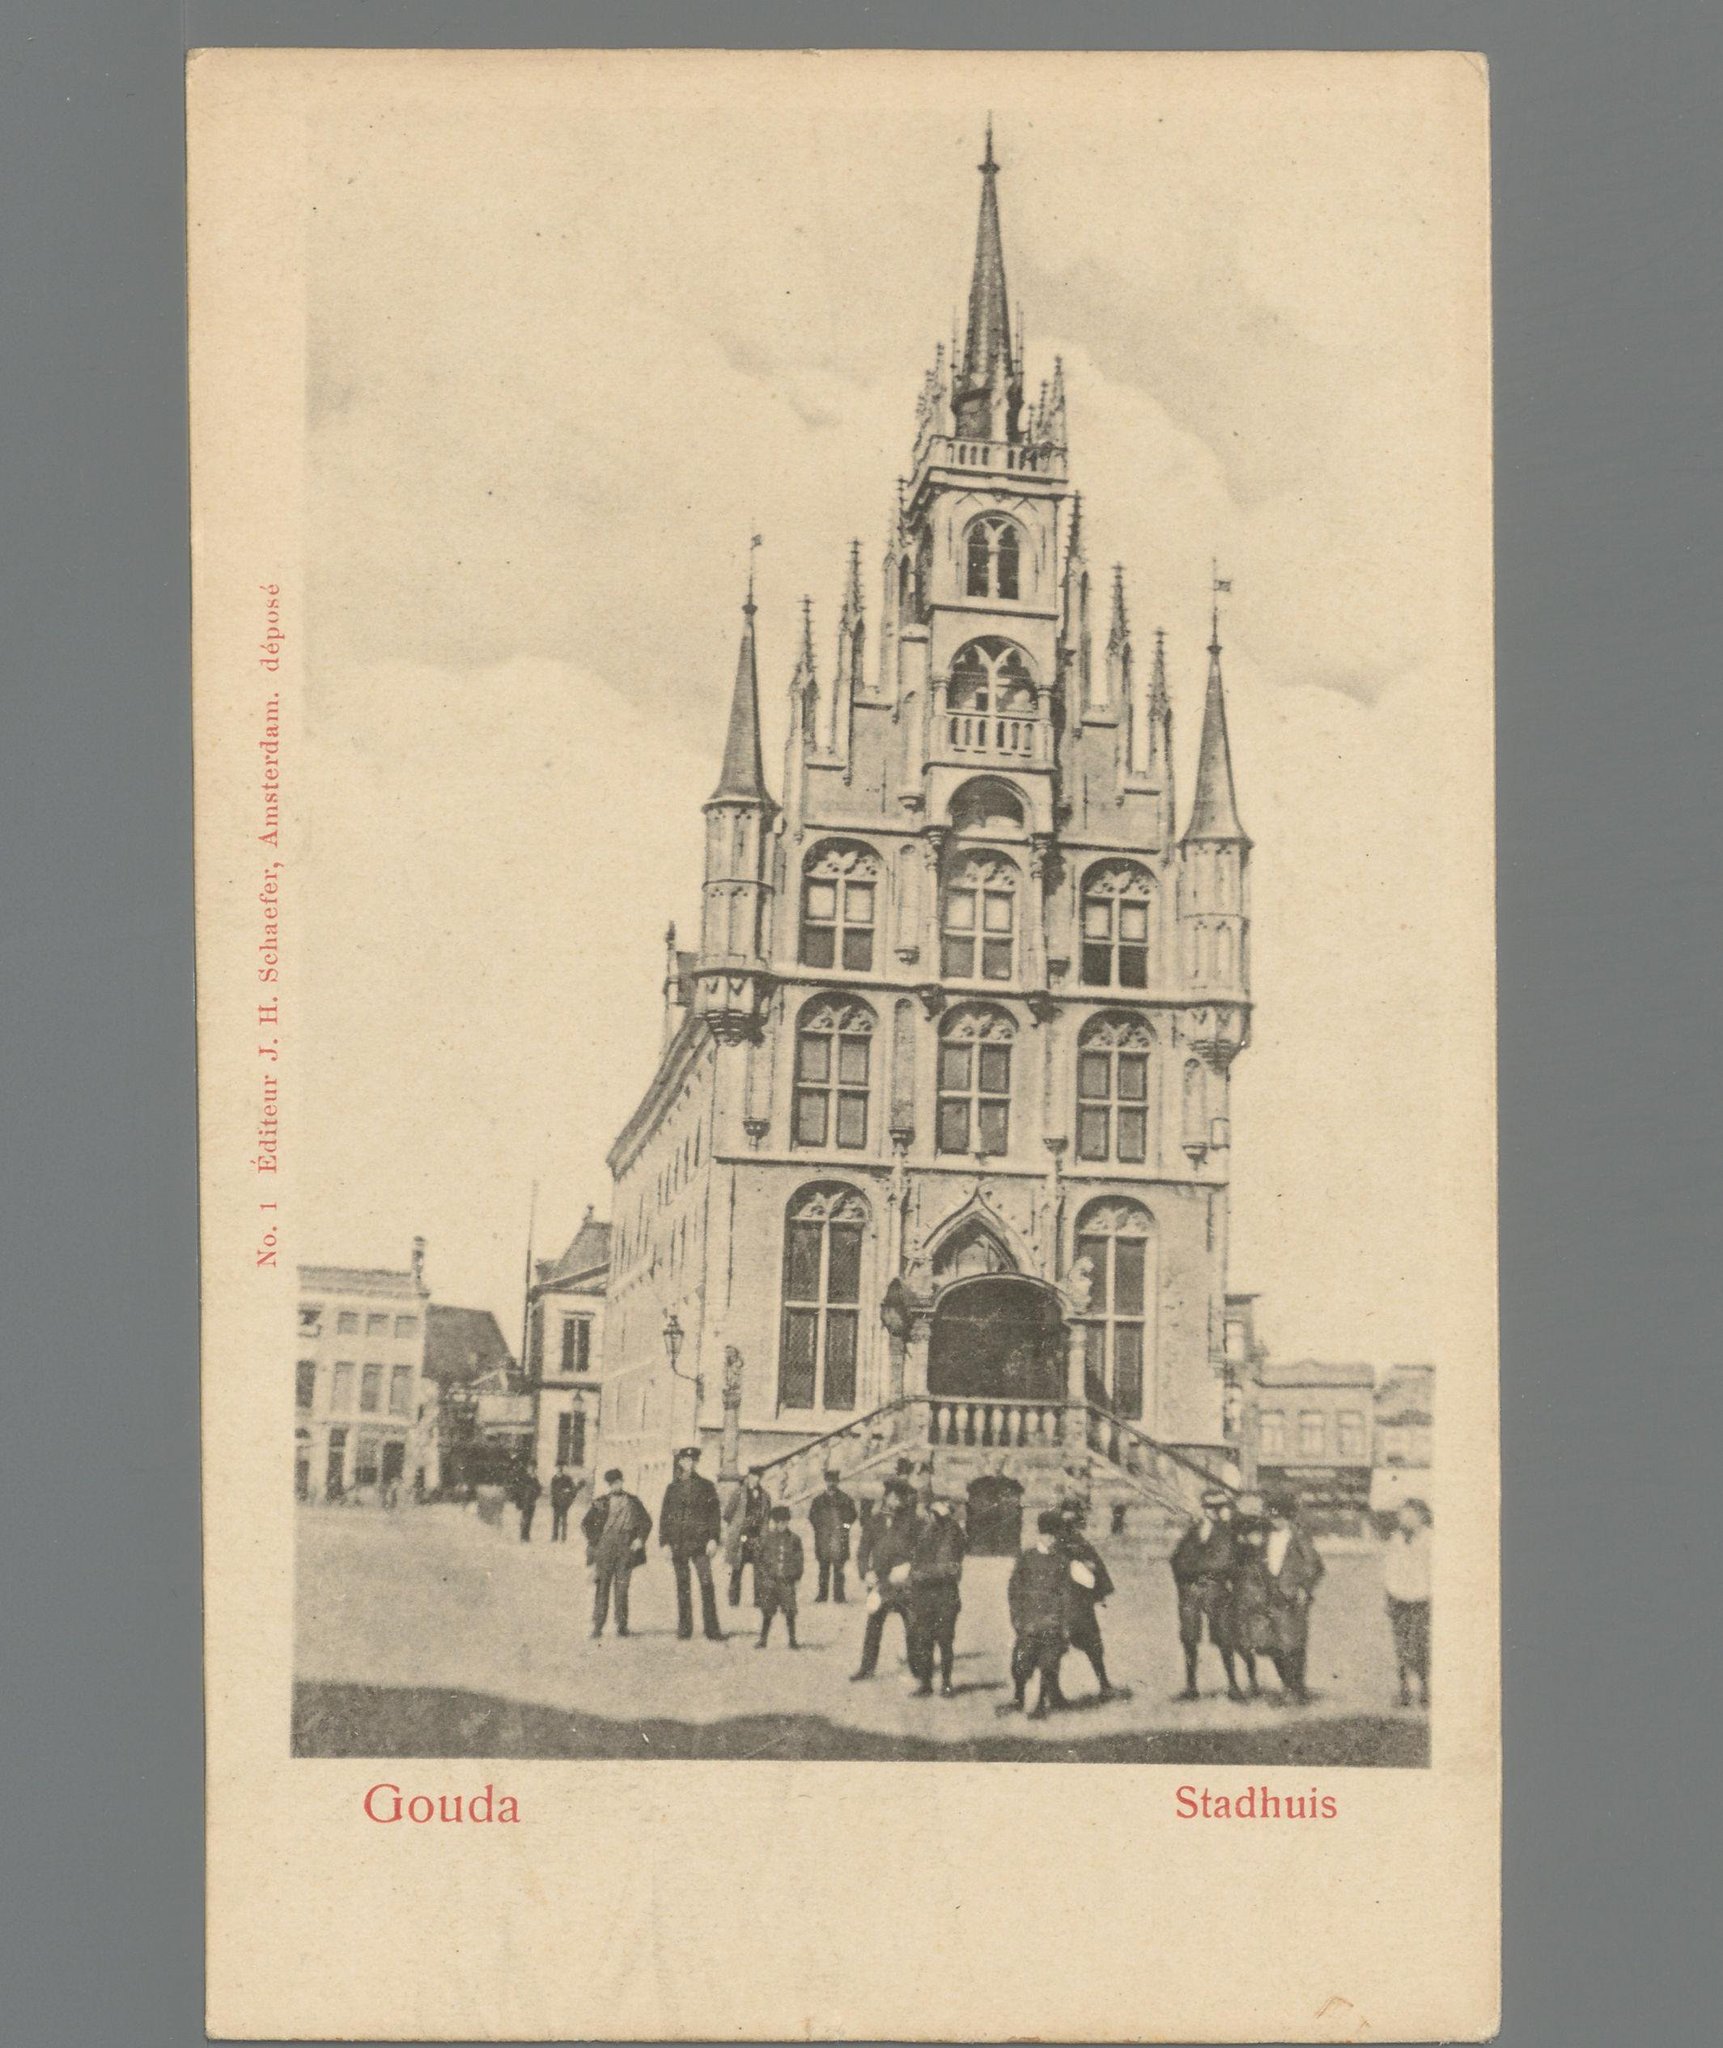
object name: photomechanical print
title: Gouda. Stadhuis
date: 1897-1905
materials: cardboard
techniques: photograph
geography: gouda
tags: square, place, circus, etc., townhall